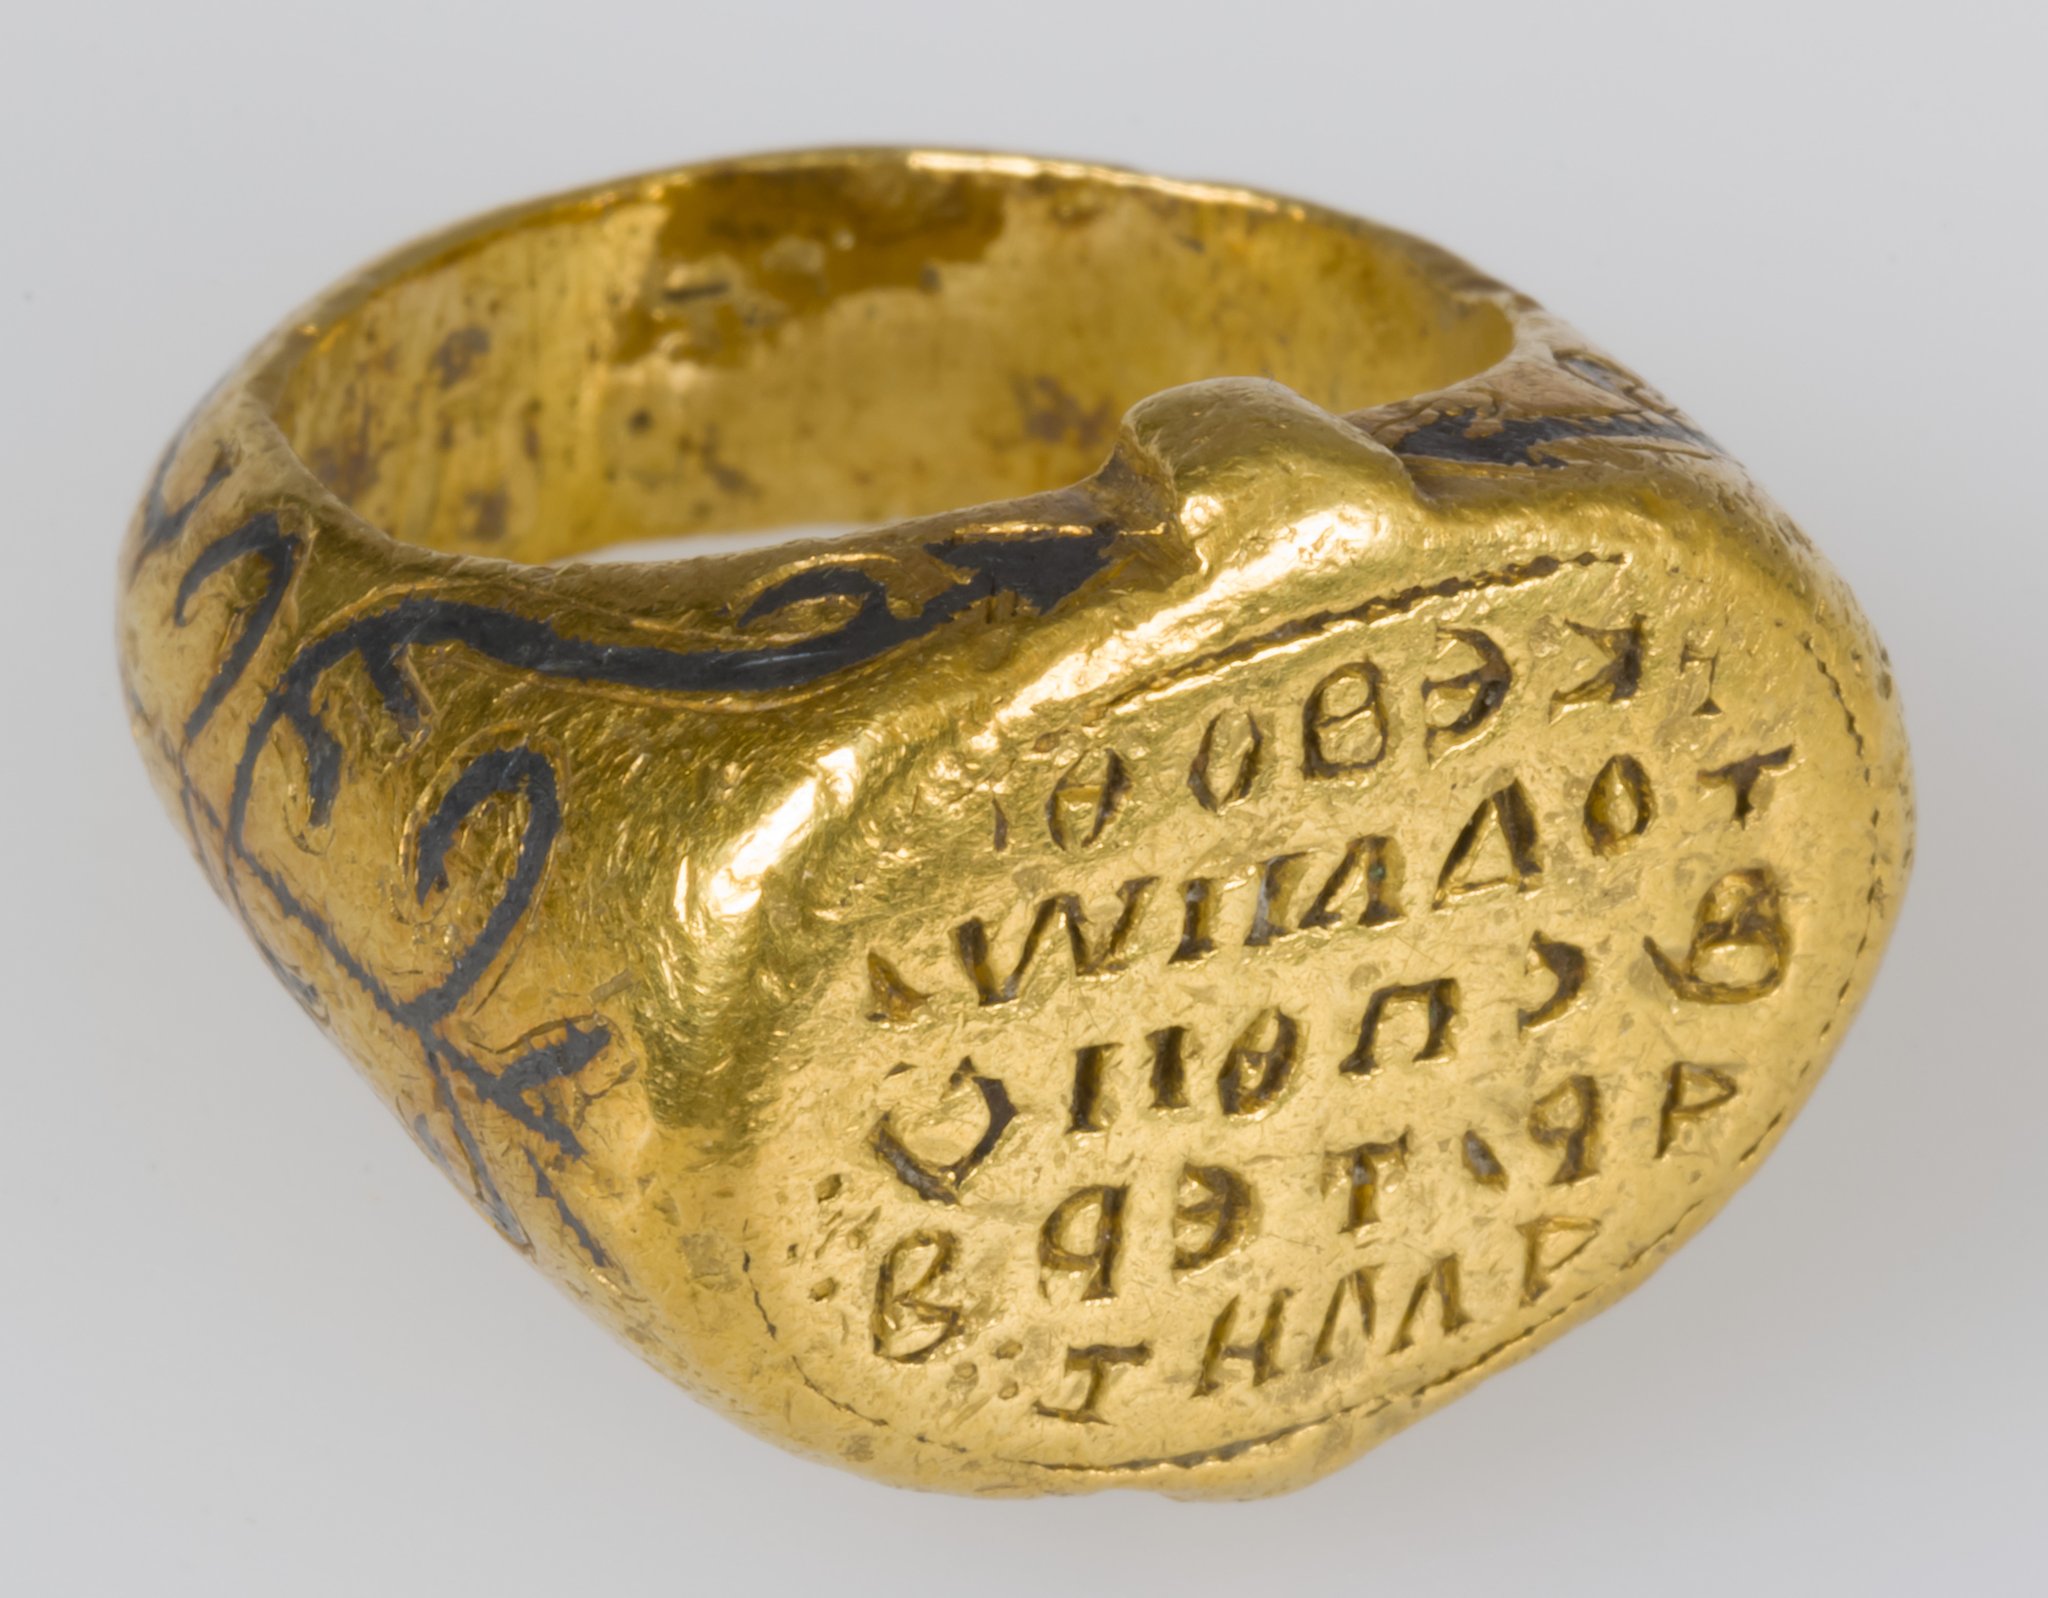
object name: ring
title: Signet Ring of John, Imperial Spatharios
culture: byzantine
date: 901-1000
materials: gold, niello